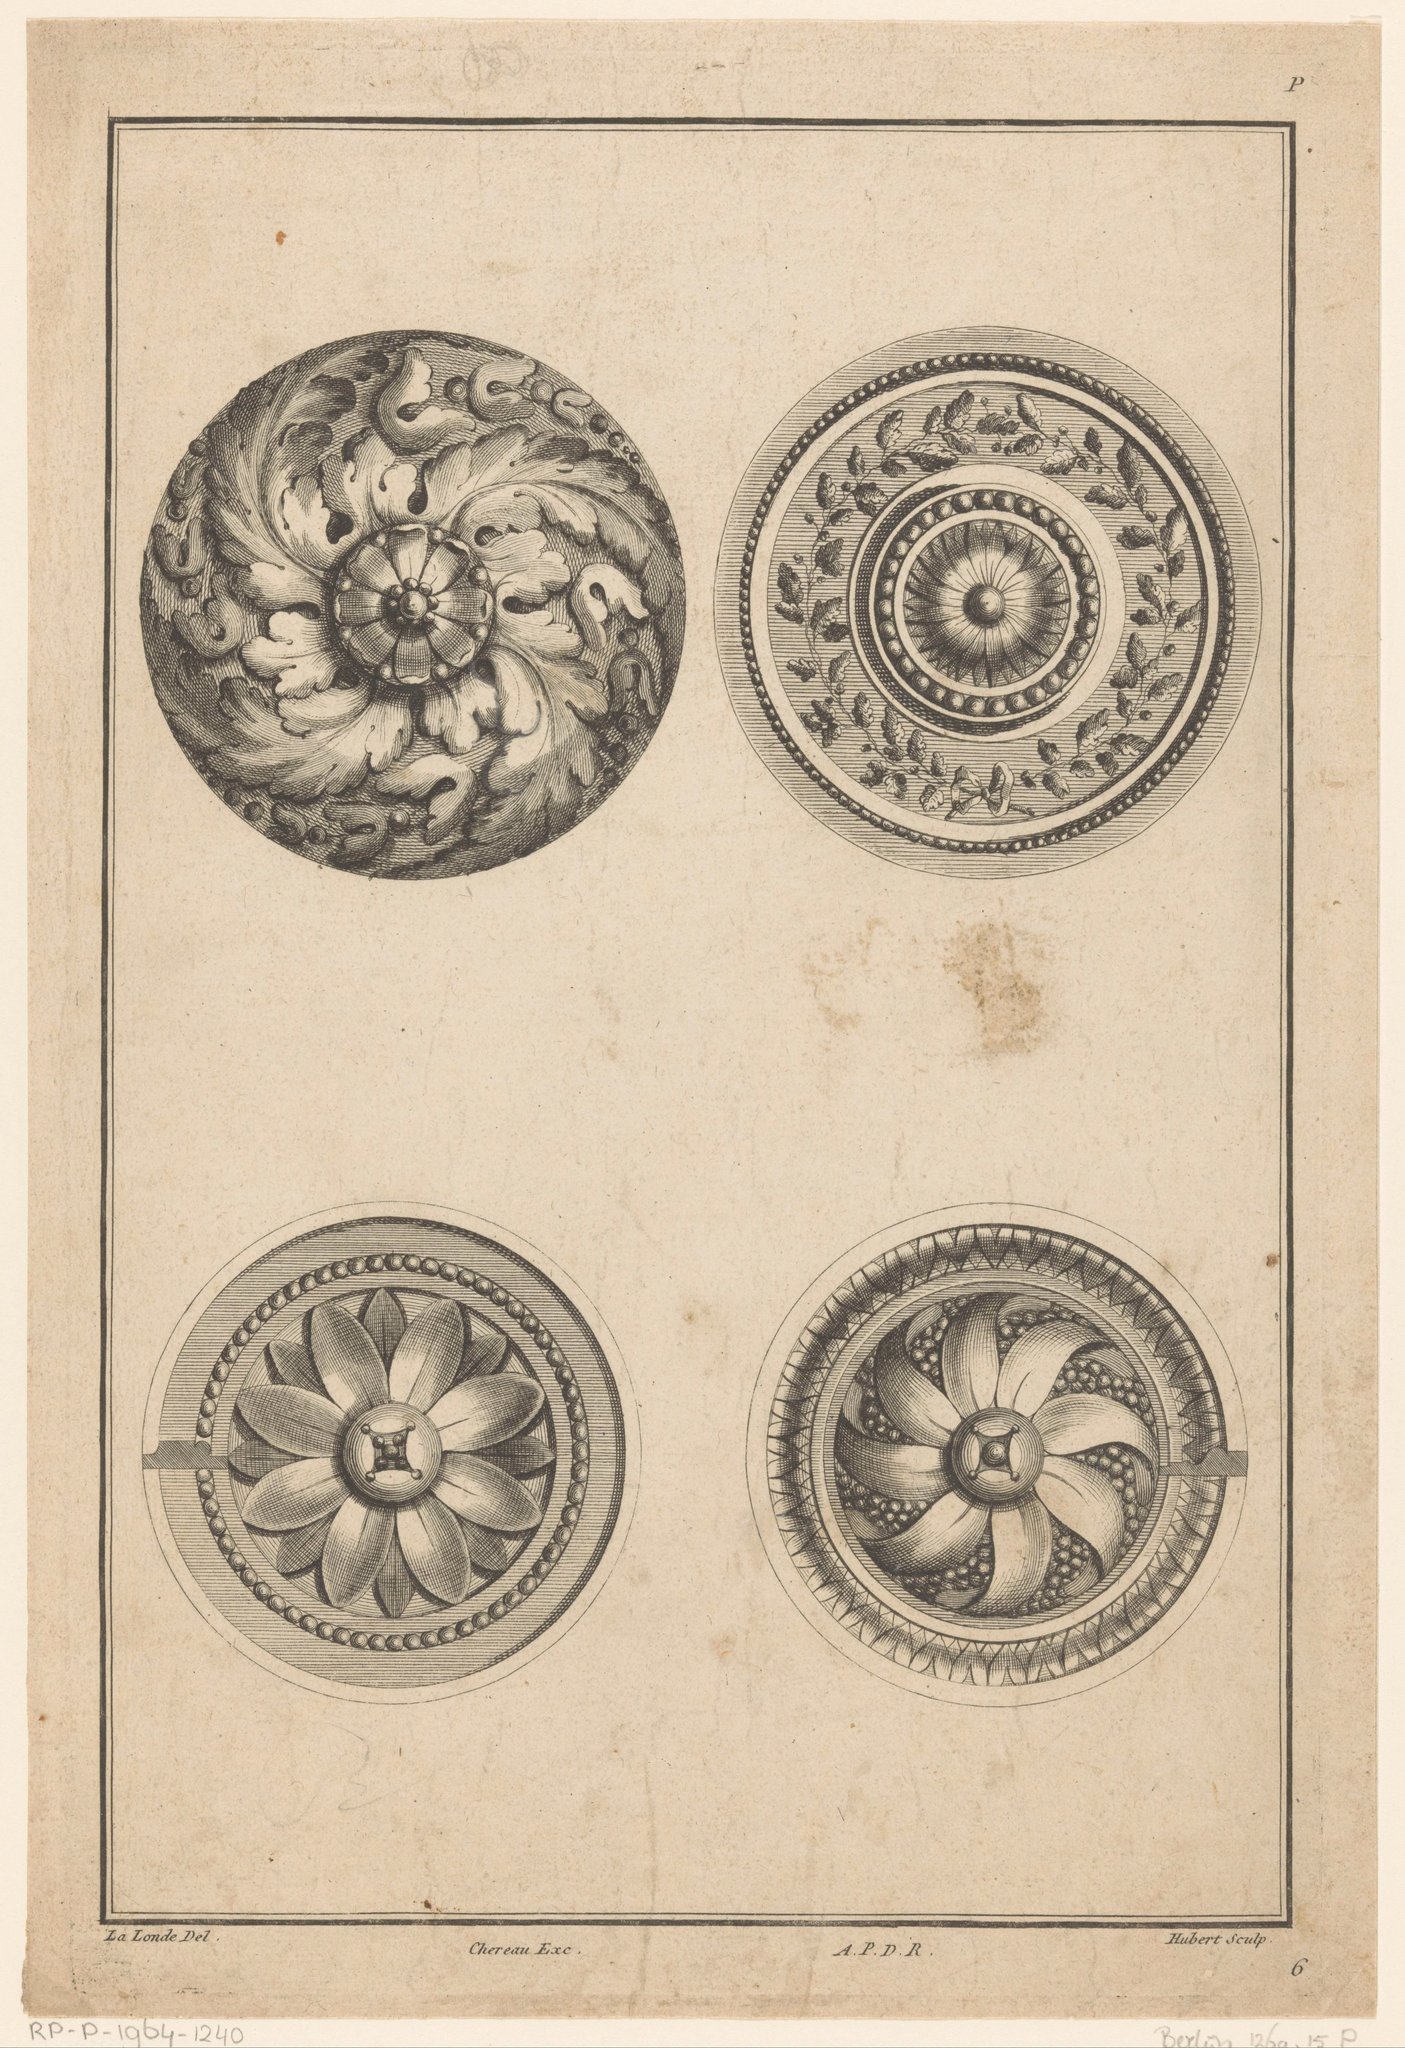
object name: print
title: Vier rozetten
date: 1784-1785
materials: paper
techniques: engraving, etching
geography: paris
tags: rosette ~ ornament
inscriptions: collector's mark: Lugt 2228, collector's mark: Lugt 2760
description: Links boven een rozet met acanthusbladeren, rechts boven een rozet met stervorm en ranken, onder twee rozetten met bloemmotief.